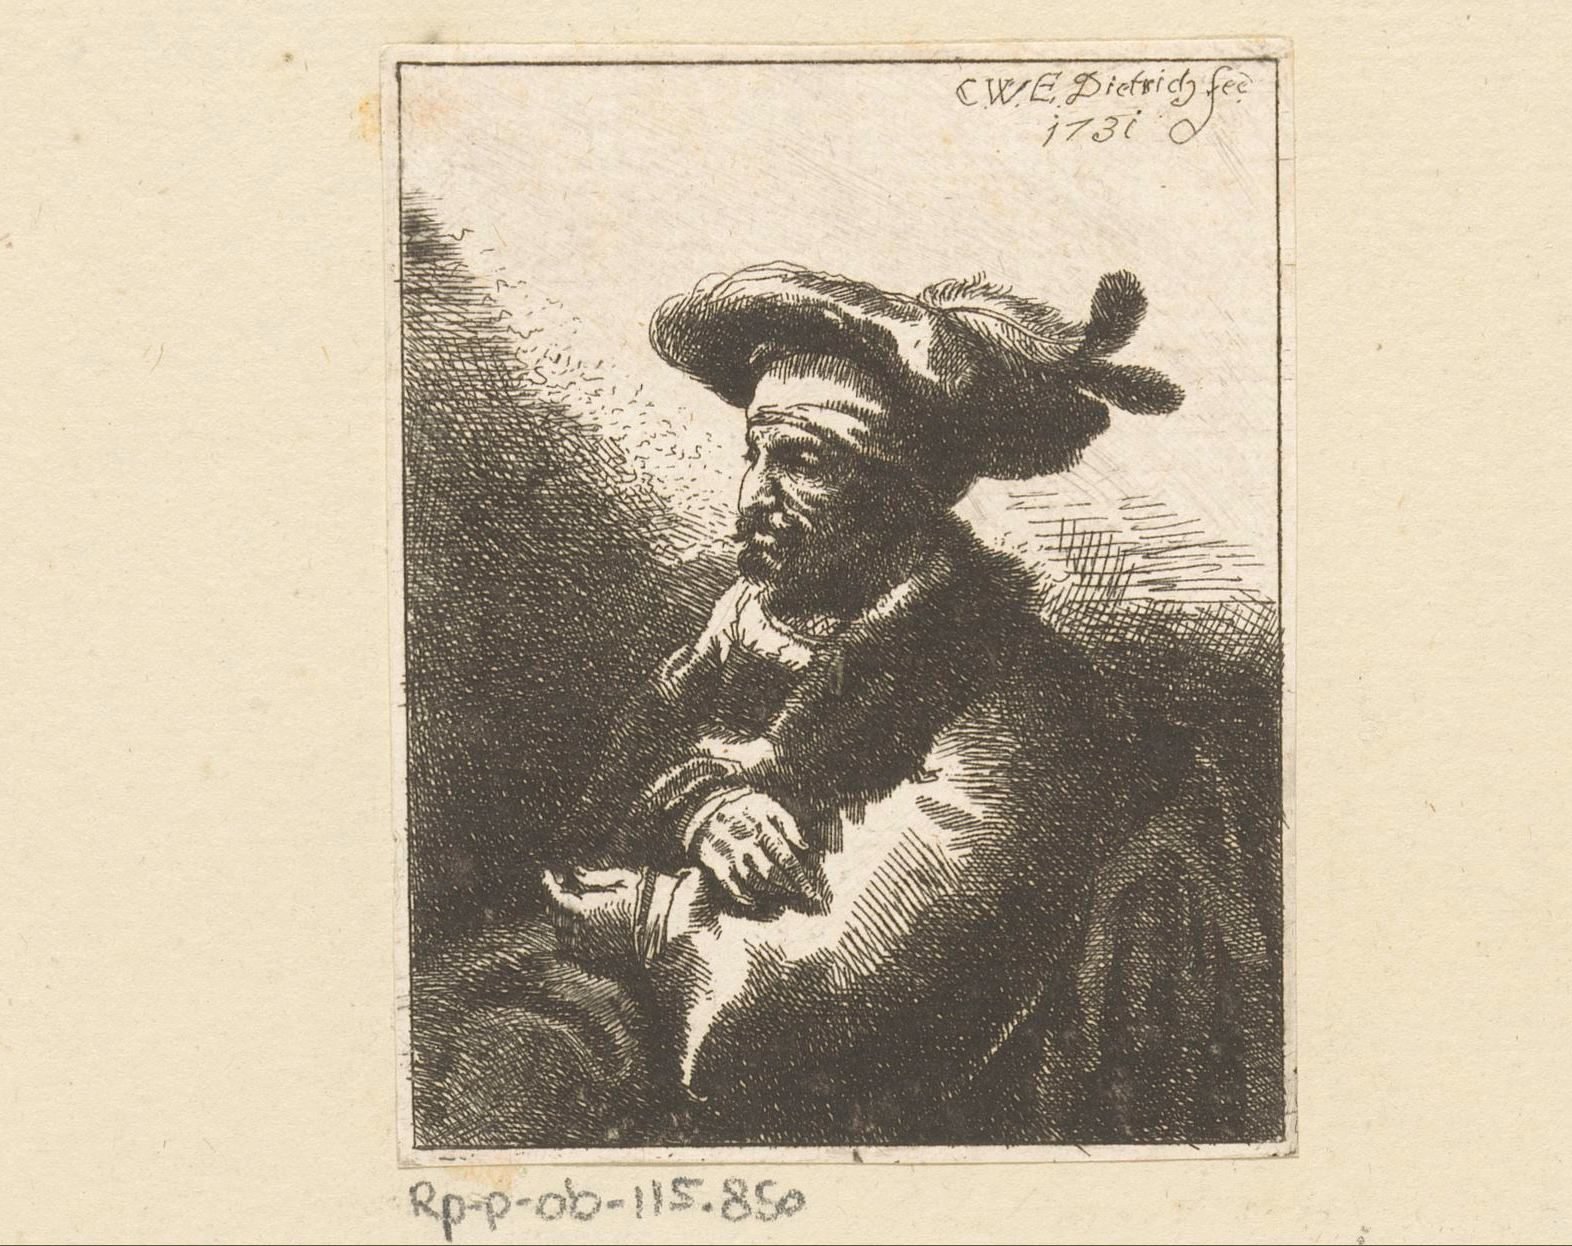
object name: print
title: Oude man met platte muts en veer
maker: christian wilhelm ernst dietrich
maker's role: artist, painter, print maker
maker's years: 1712-1774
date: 1731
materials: paper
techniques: etching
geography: germany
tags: arms crossed, head-gear: cap (+ men's clothes), old man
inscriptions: collector's mark: Lugt 240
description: Afdruk in spiegelbeeld van Linck 91. Mogelijk een kopie.